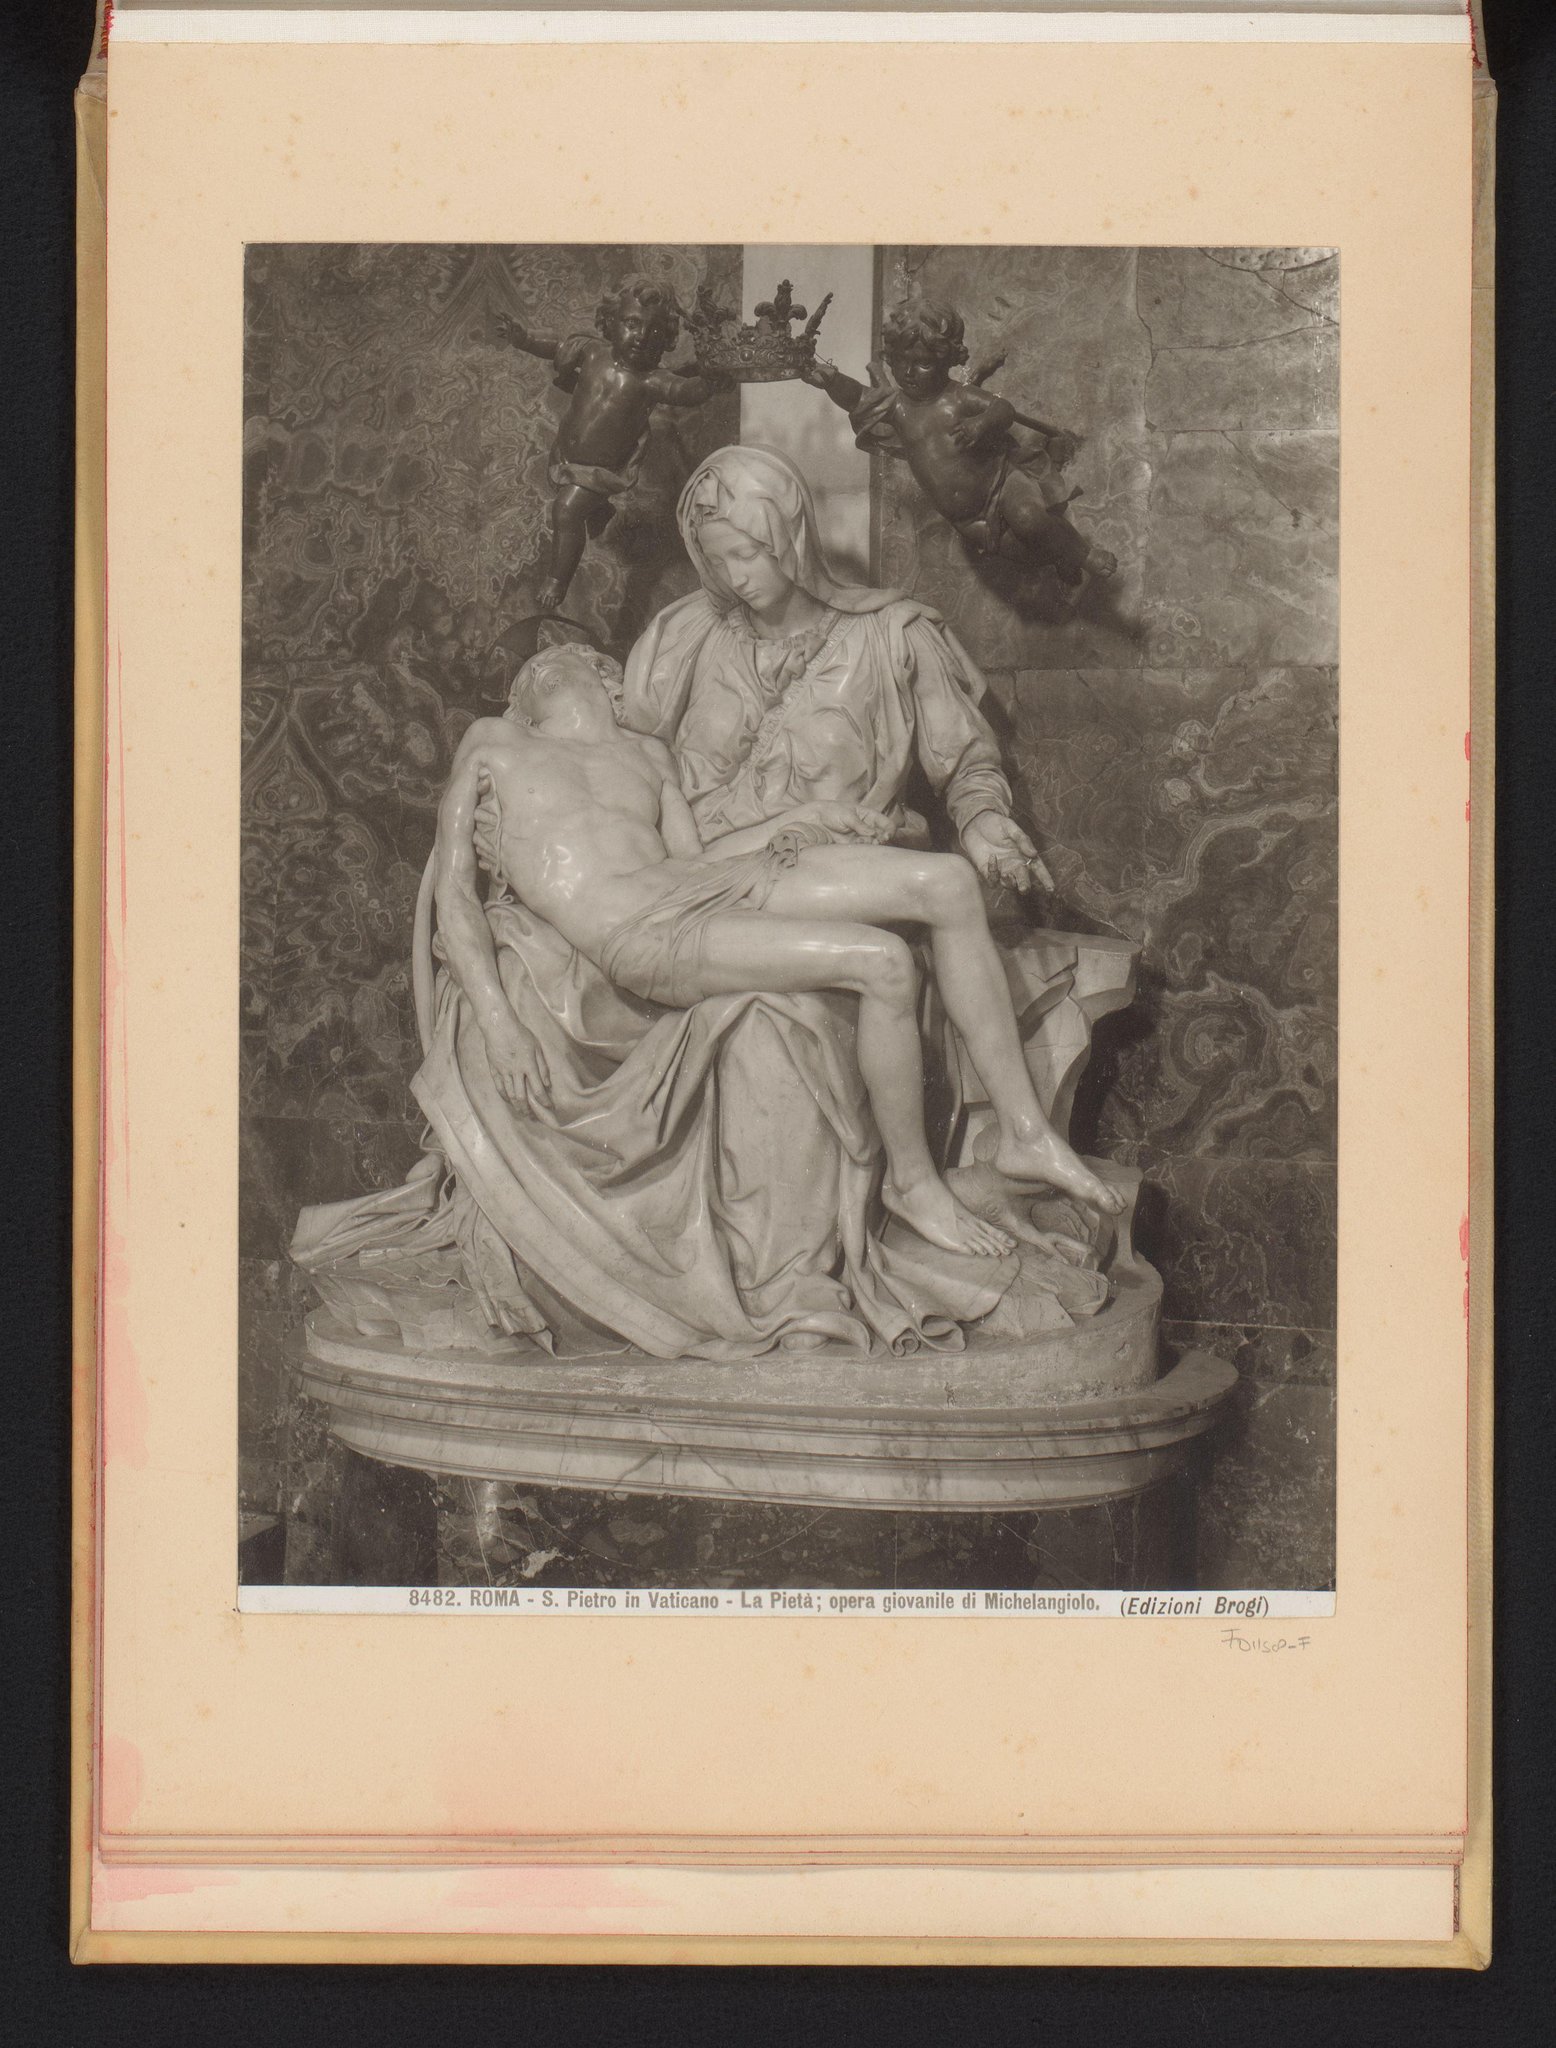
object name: photograph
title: Sculptuur in de Sint-Pietersbasiliek, voorstellende de Piëta van Michelangelo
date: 1875-1907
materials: photographic support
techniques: gelatin silver print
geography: sint-pietersplein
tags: 'pietà ', 'vesperbild', 'marienklage' (no others present): christ, either with or without crown of thorns, mourned by mary, interior of church, sculpture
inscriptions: number: ‘8482’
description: Onderdeel van Fotoalbum met opnames van bezienswaardigheden en kunstwerken in Italië.